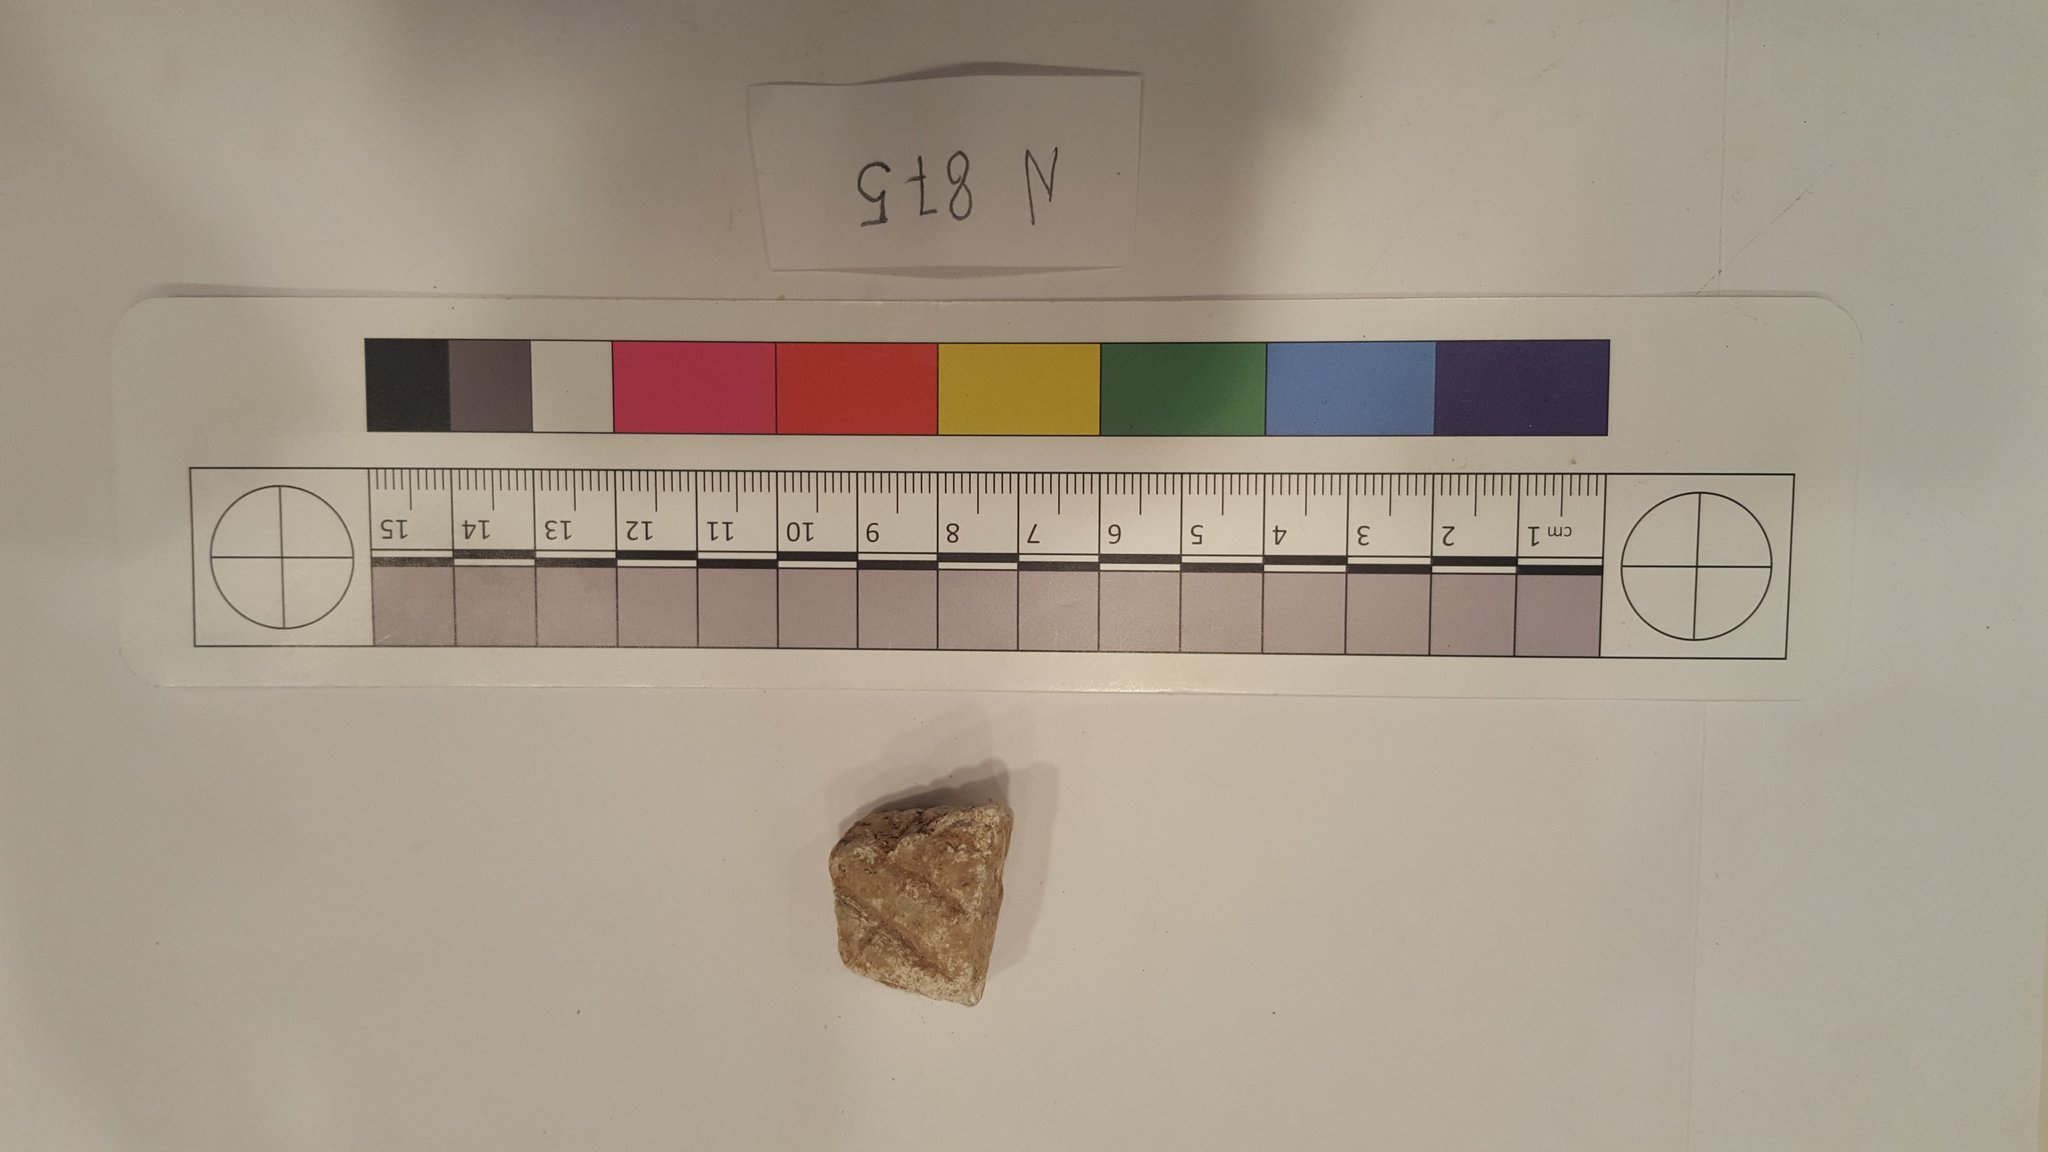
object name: fragment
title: Stucco Fragment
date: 701-1200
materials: plaster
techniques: carving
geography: iran